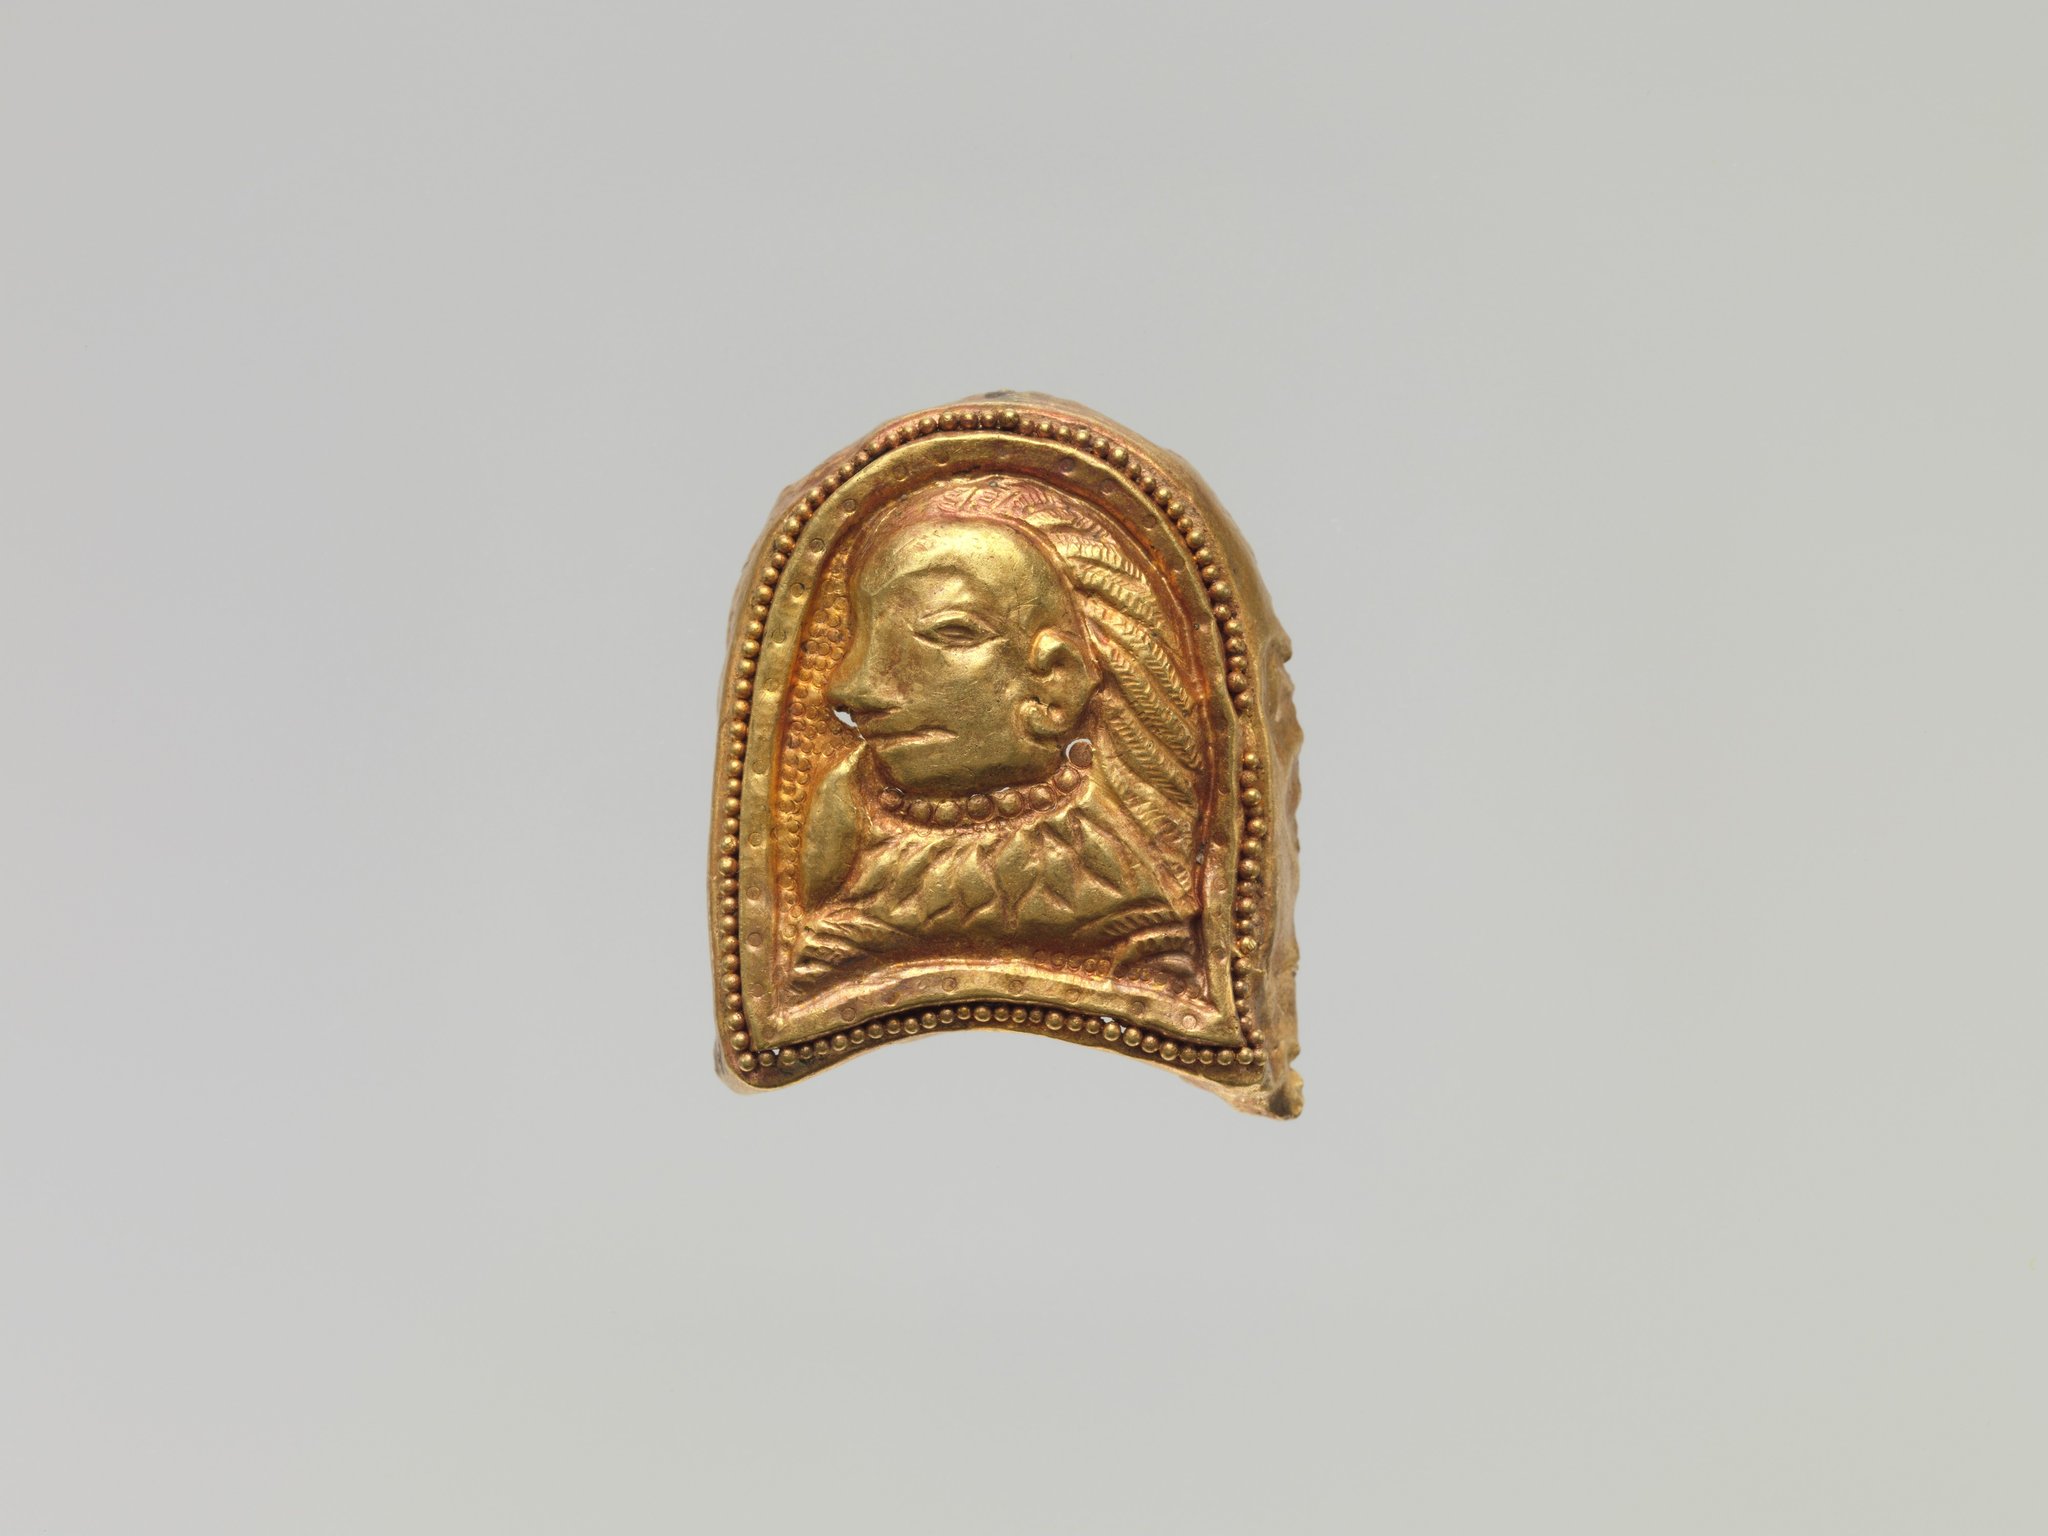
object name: plaque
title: Plaque with Head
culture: chinese or central asian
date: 601-900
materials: gold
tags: heads